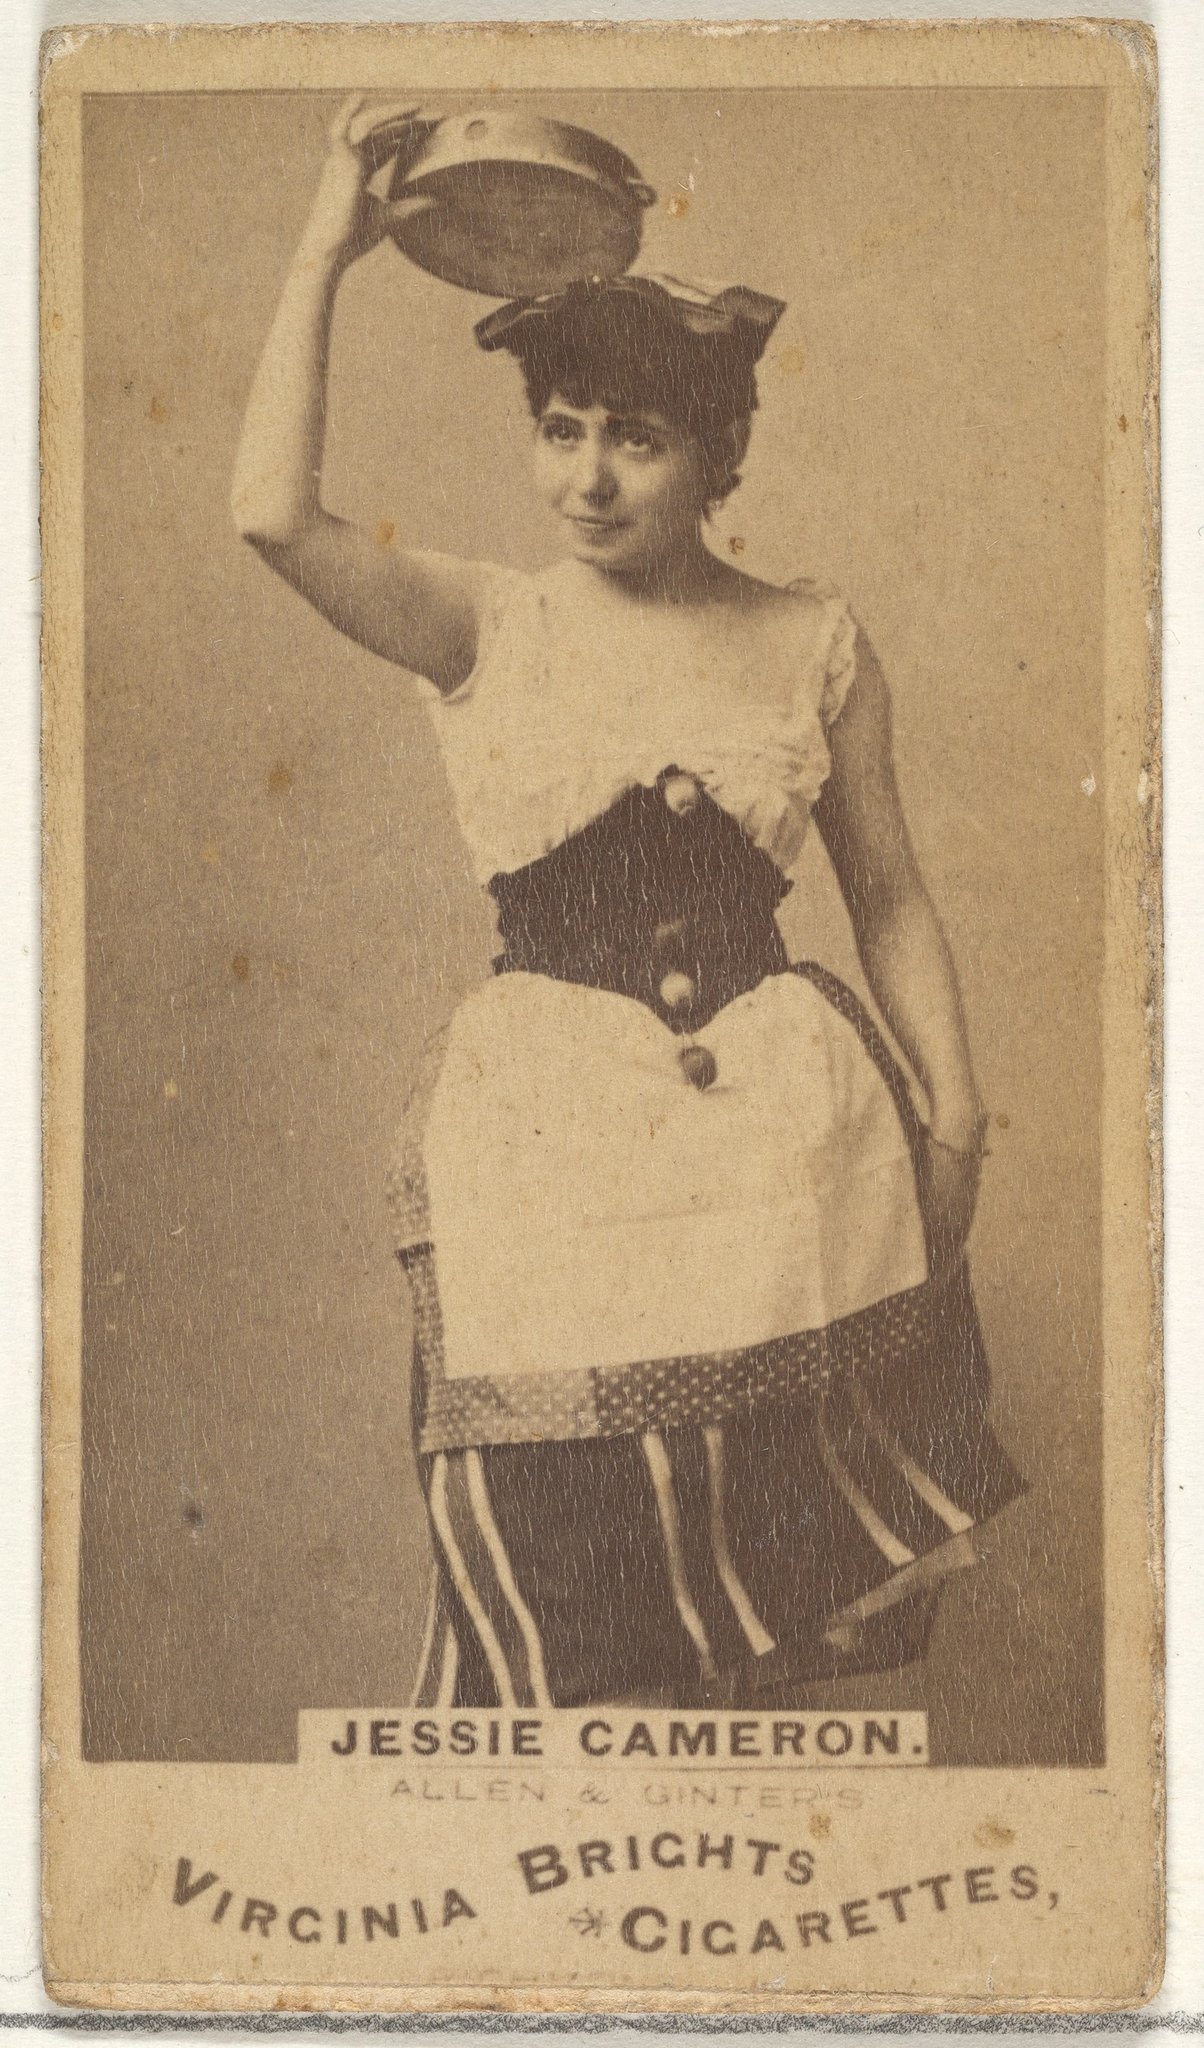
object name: photograph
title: Jessie Cameron, from the Actors and Actresses series (N45, Type 1) for Virginia Brights Cigarettes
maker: allen & ginter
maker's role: publisher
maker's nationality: american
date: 1888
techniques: albumen silver print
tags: portraits,women,actresses